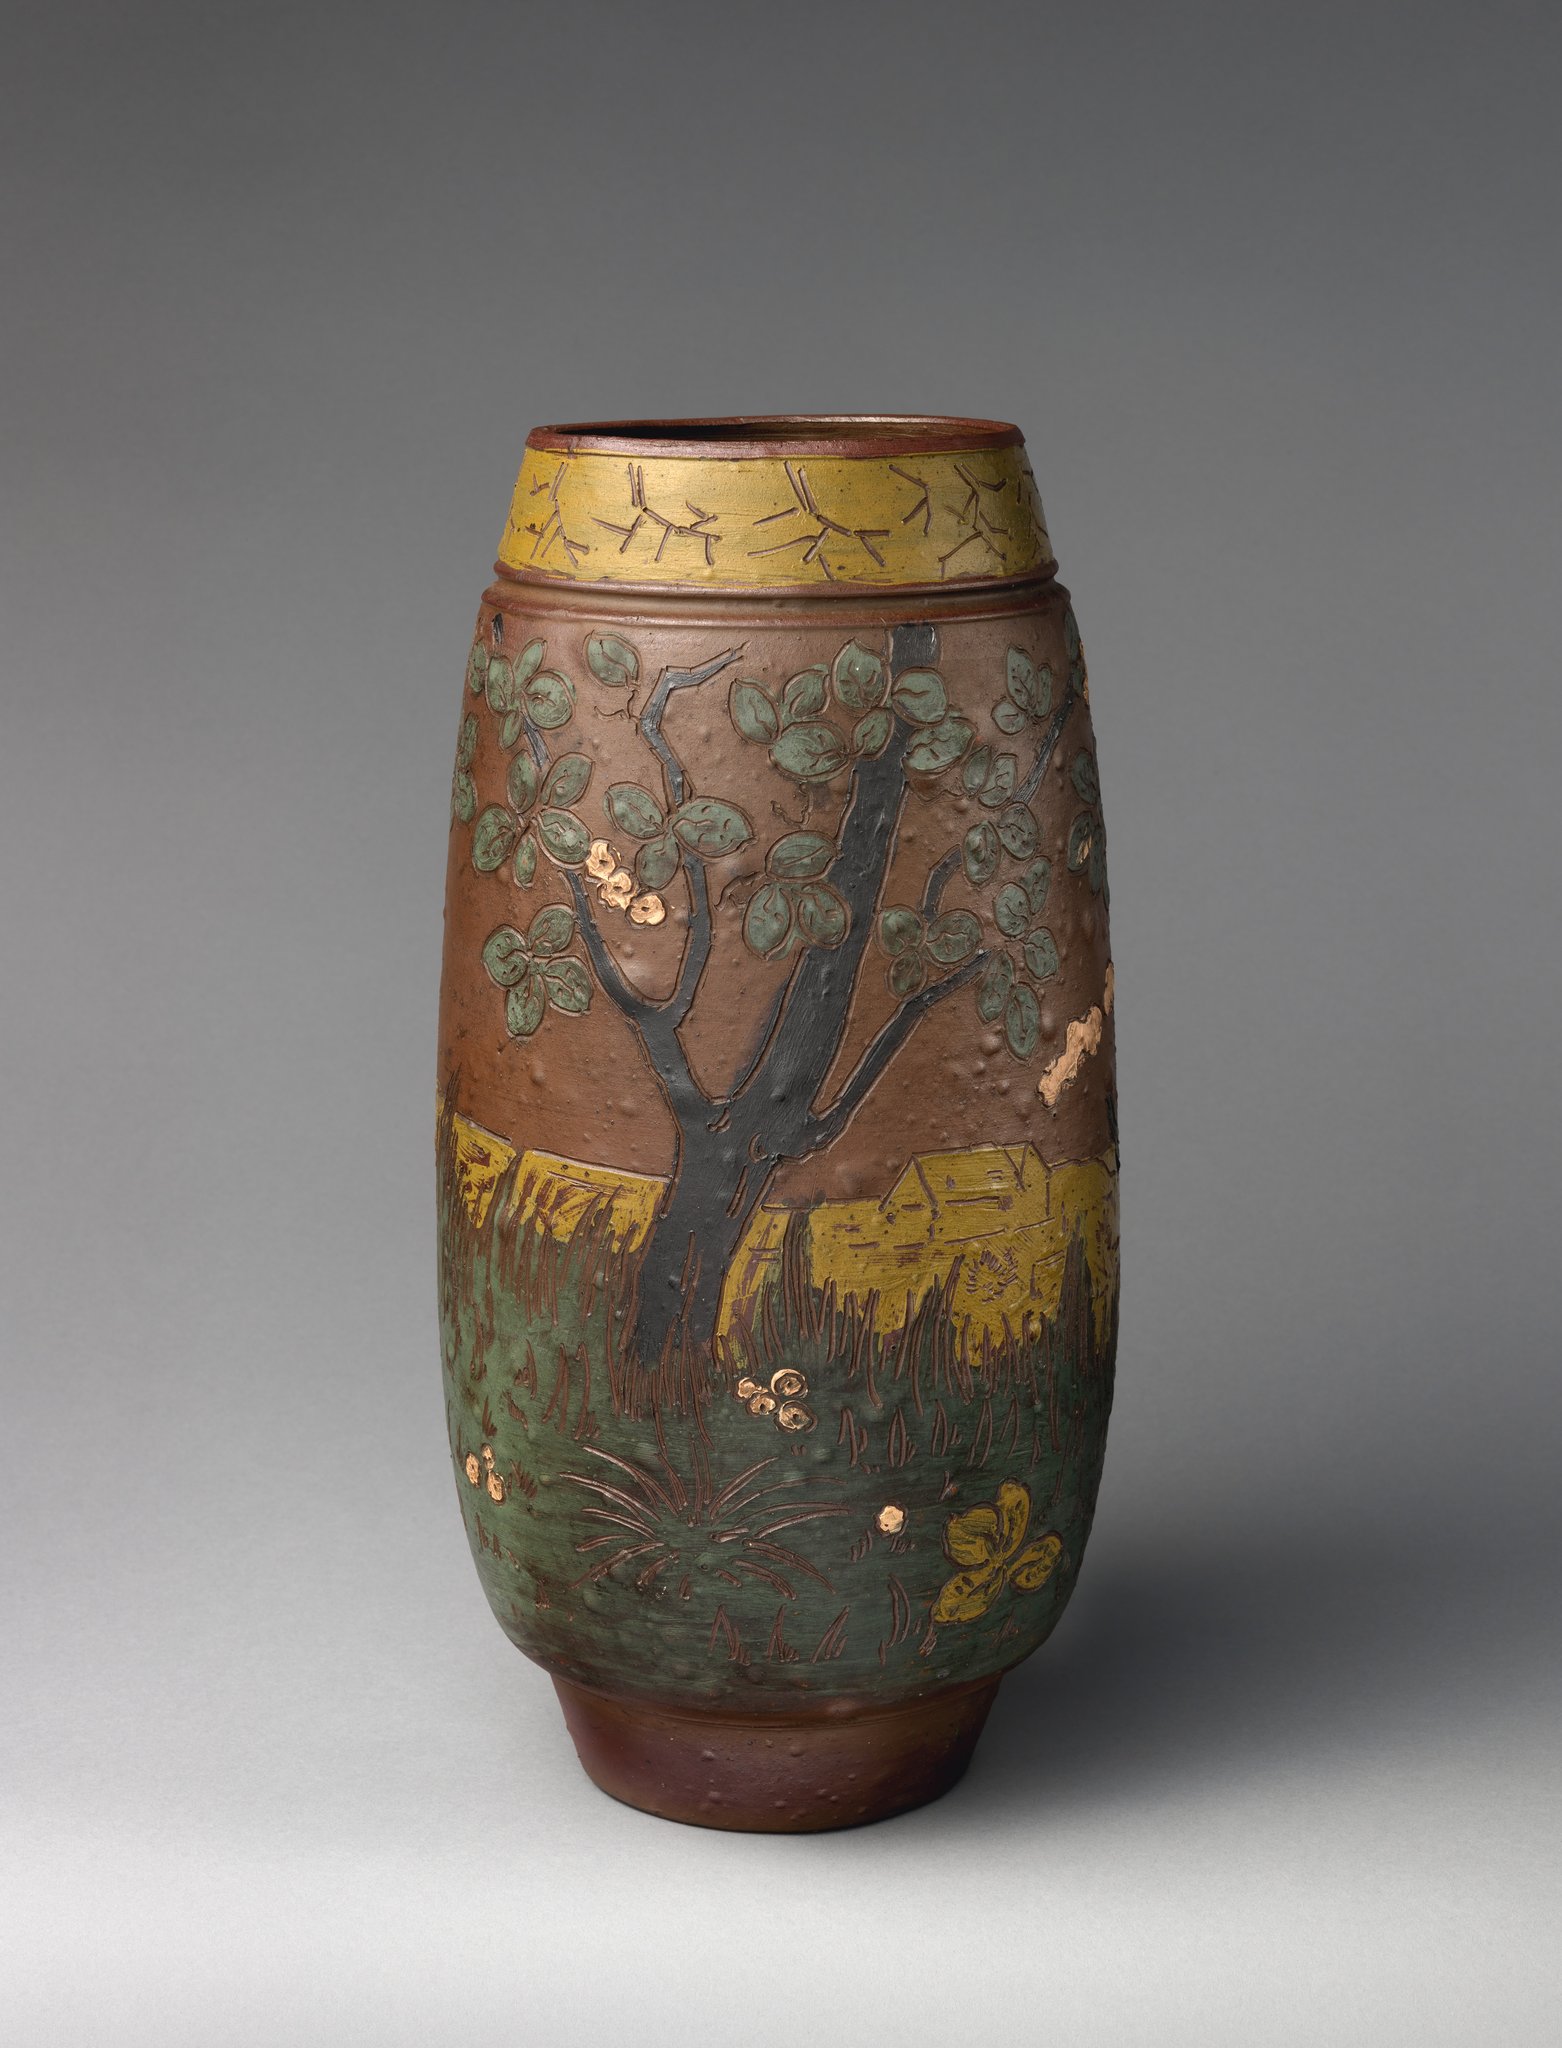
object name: vase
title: Vase with reaper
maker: haviland & co.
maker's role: manufactory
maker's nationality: american and french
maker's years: 1864-1931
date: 1885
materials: stoneware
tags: houses,trees